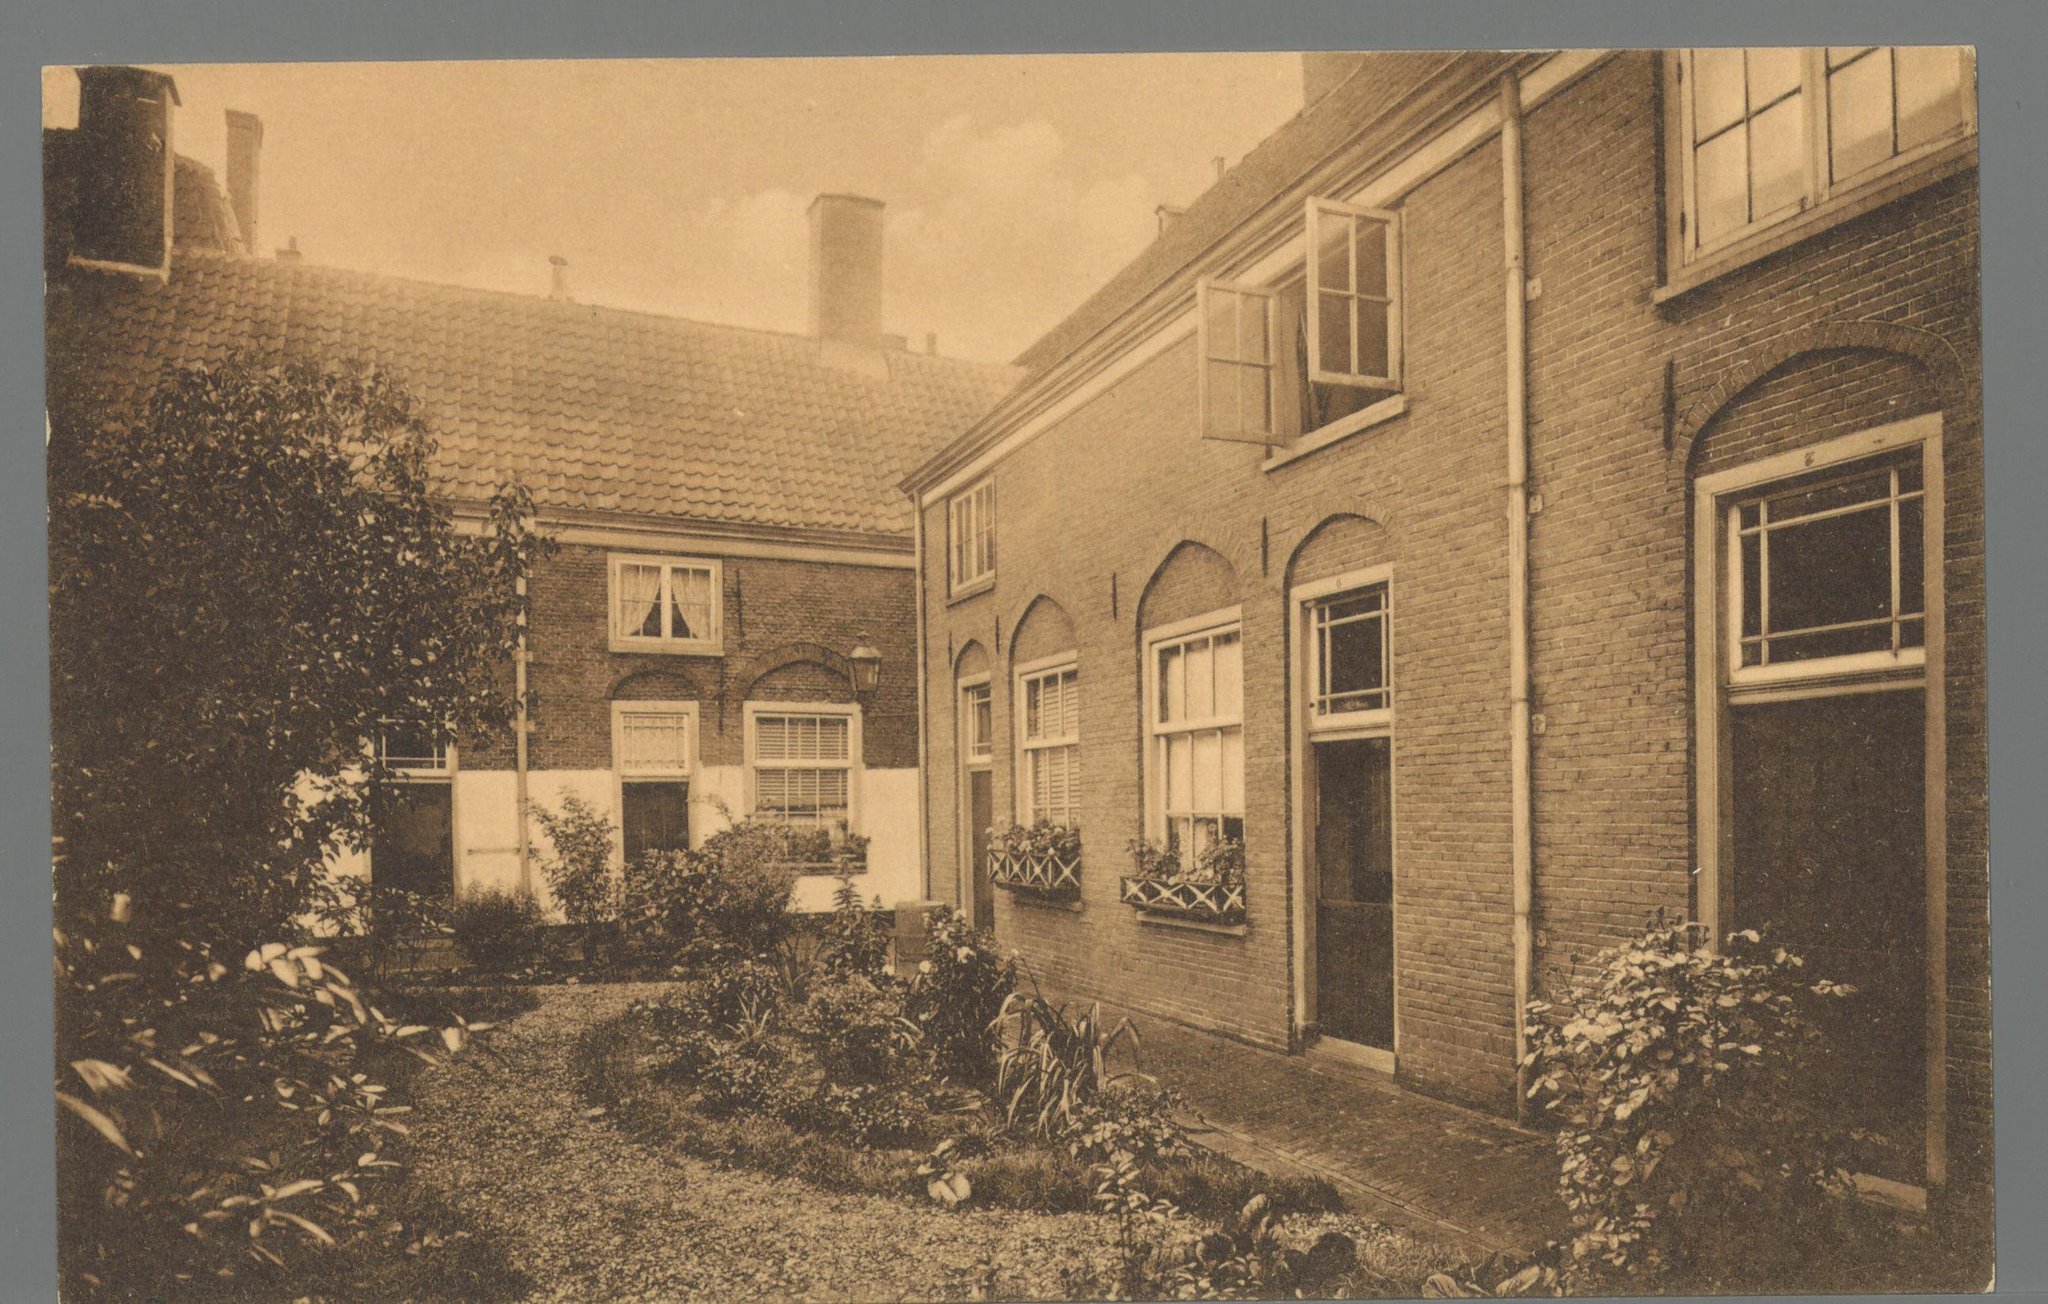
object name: ansichtkaart, prentbriefkaart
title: Leiden. St. Salvator's hofje - Steenstraat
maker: Anonymous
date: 1910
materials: cardboard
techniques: photograph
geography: leiden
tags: alms-house (dutch: 'hofje')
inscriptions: date